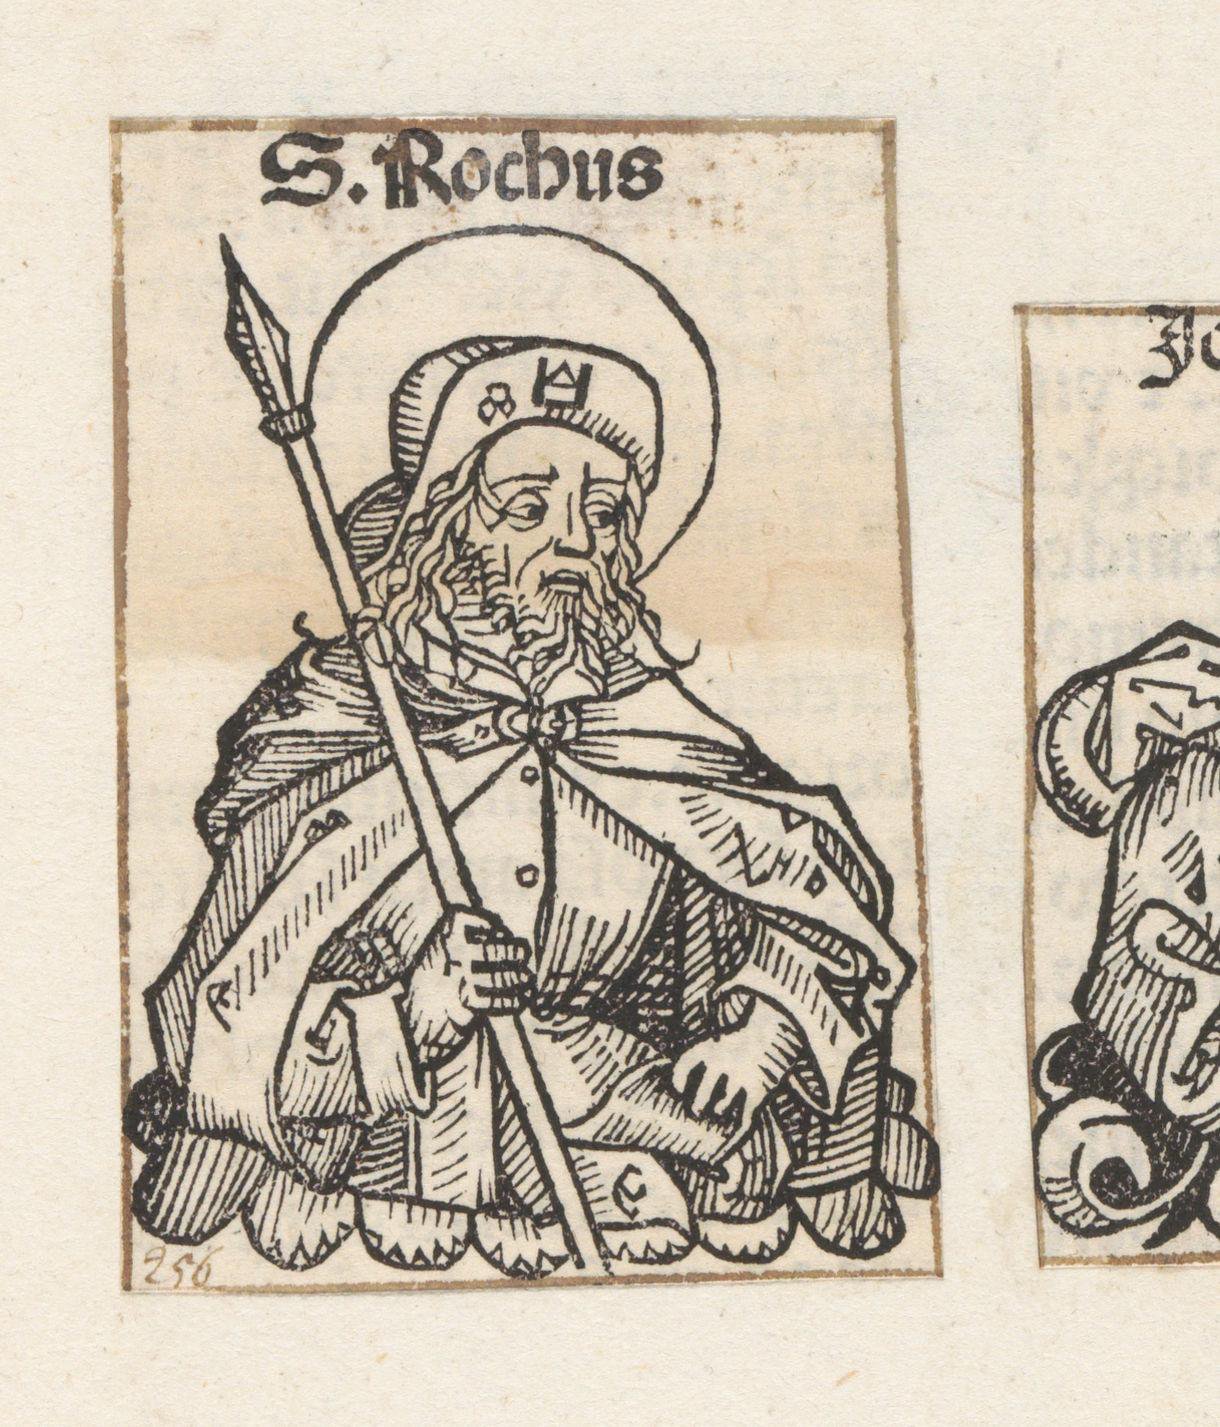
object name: print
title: S. Rochus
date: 1493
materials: paper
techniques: letterpress printing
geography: nuremberg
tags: the confessor and pilgrim roch(us) (rocco, rock) of montpellier; possible attributes: angel (with ointment box or spoon), dog (sometimes with loaf), (pointing at) plague-spot on thigh, pilgrim's shell, staff, hat and wallet, pilgrim(s)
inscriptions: inscription: ‘256’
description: Een bloemkelk met een heilige. De man draagt een pelgrimshoed en een pelgrimsstaf of speer. Hij toont een pestbuil op zijn lichaam. De tekst identificeert hem als de heilige Rochus. De prent maakt deel uit van een album.